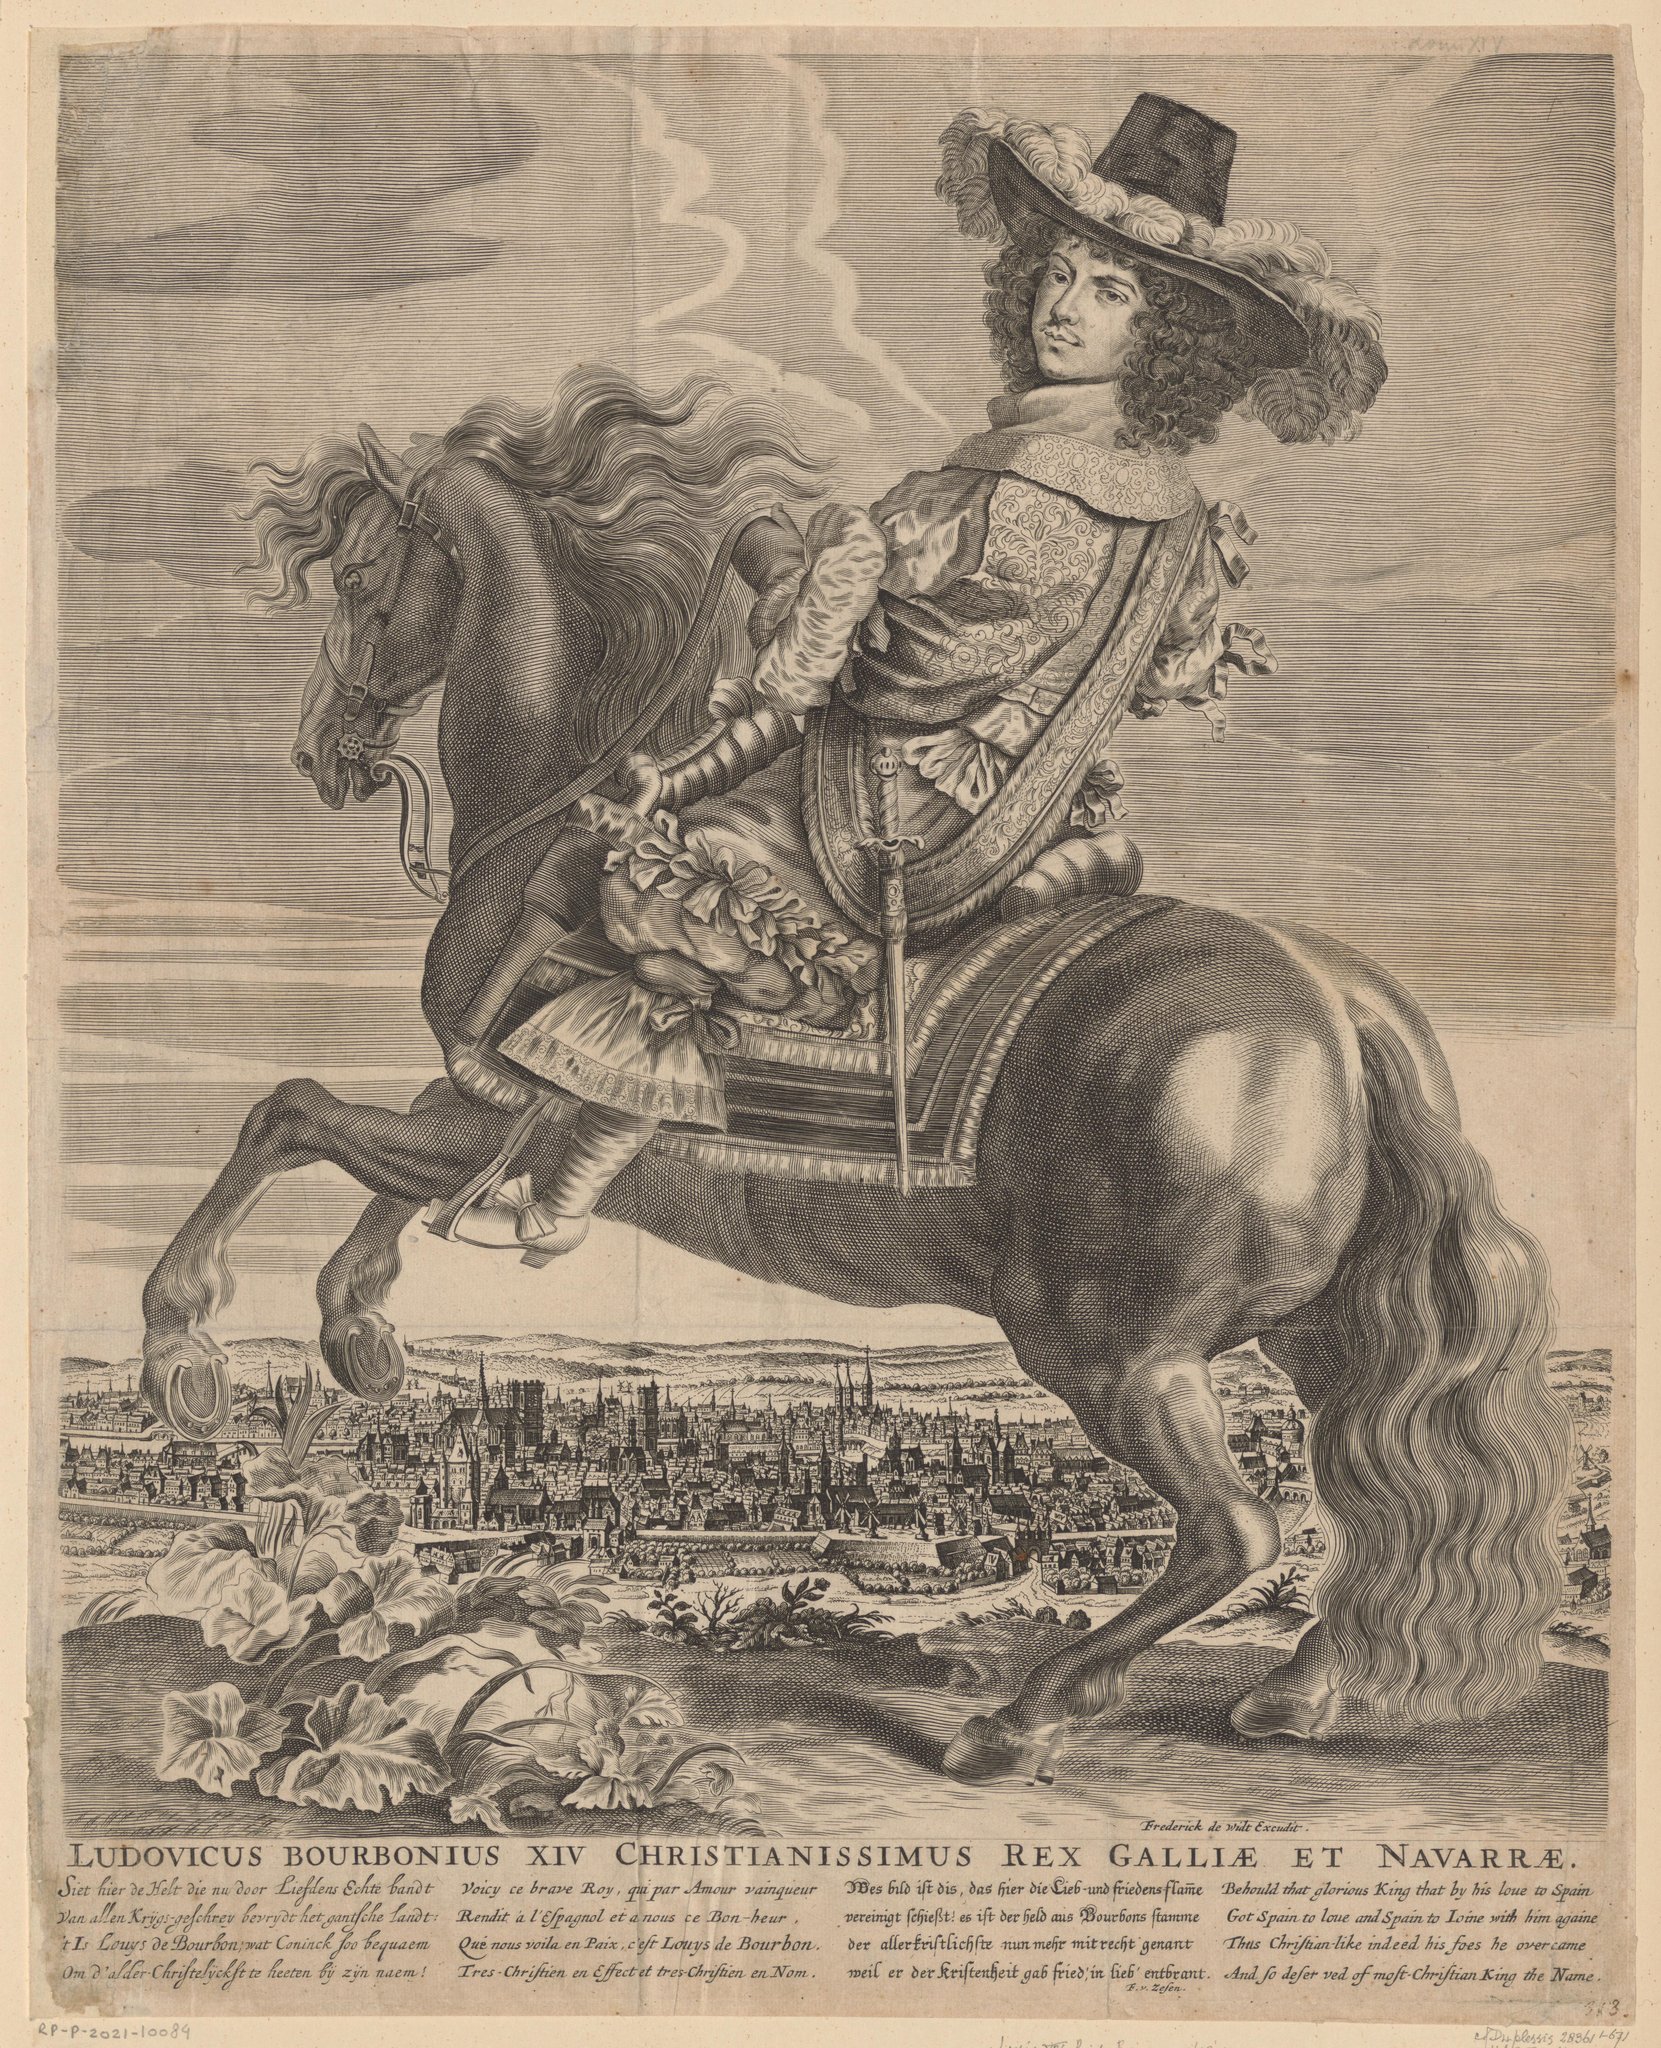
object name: print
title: Ruiterportret van Lodewijk XIV, koning van Frankrijk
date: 1651-1712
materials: paper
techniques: engraving, etching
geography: amsterdam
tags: lodewijk xiv (koning van frankrijk), equestrian state-portrait, historical persons, king, paris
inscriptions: collector's mark: Lugt 2228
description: Op de achtergrond een stadsgezicht van Parijs.